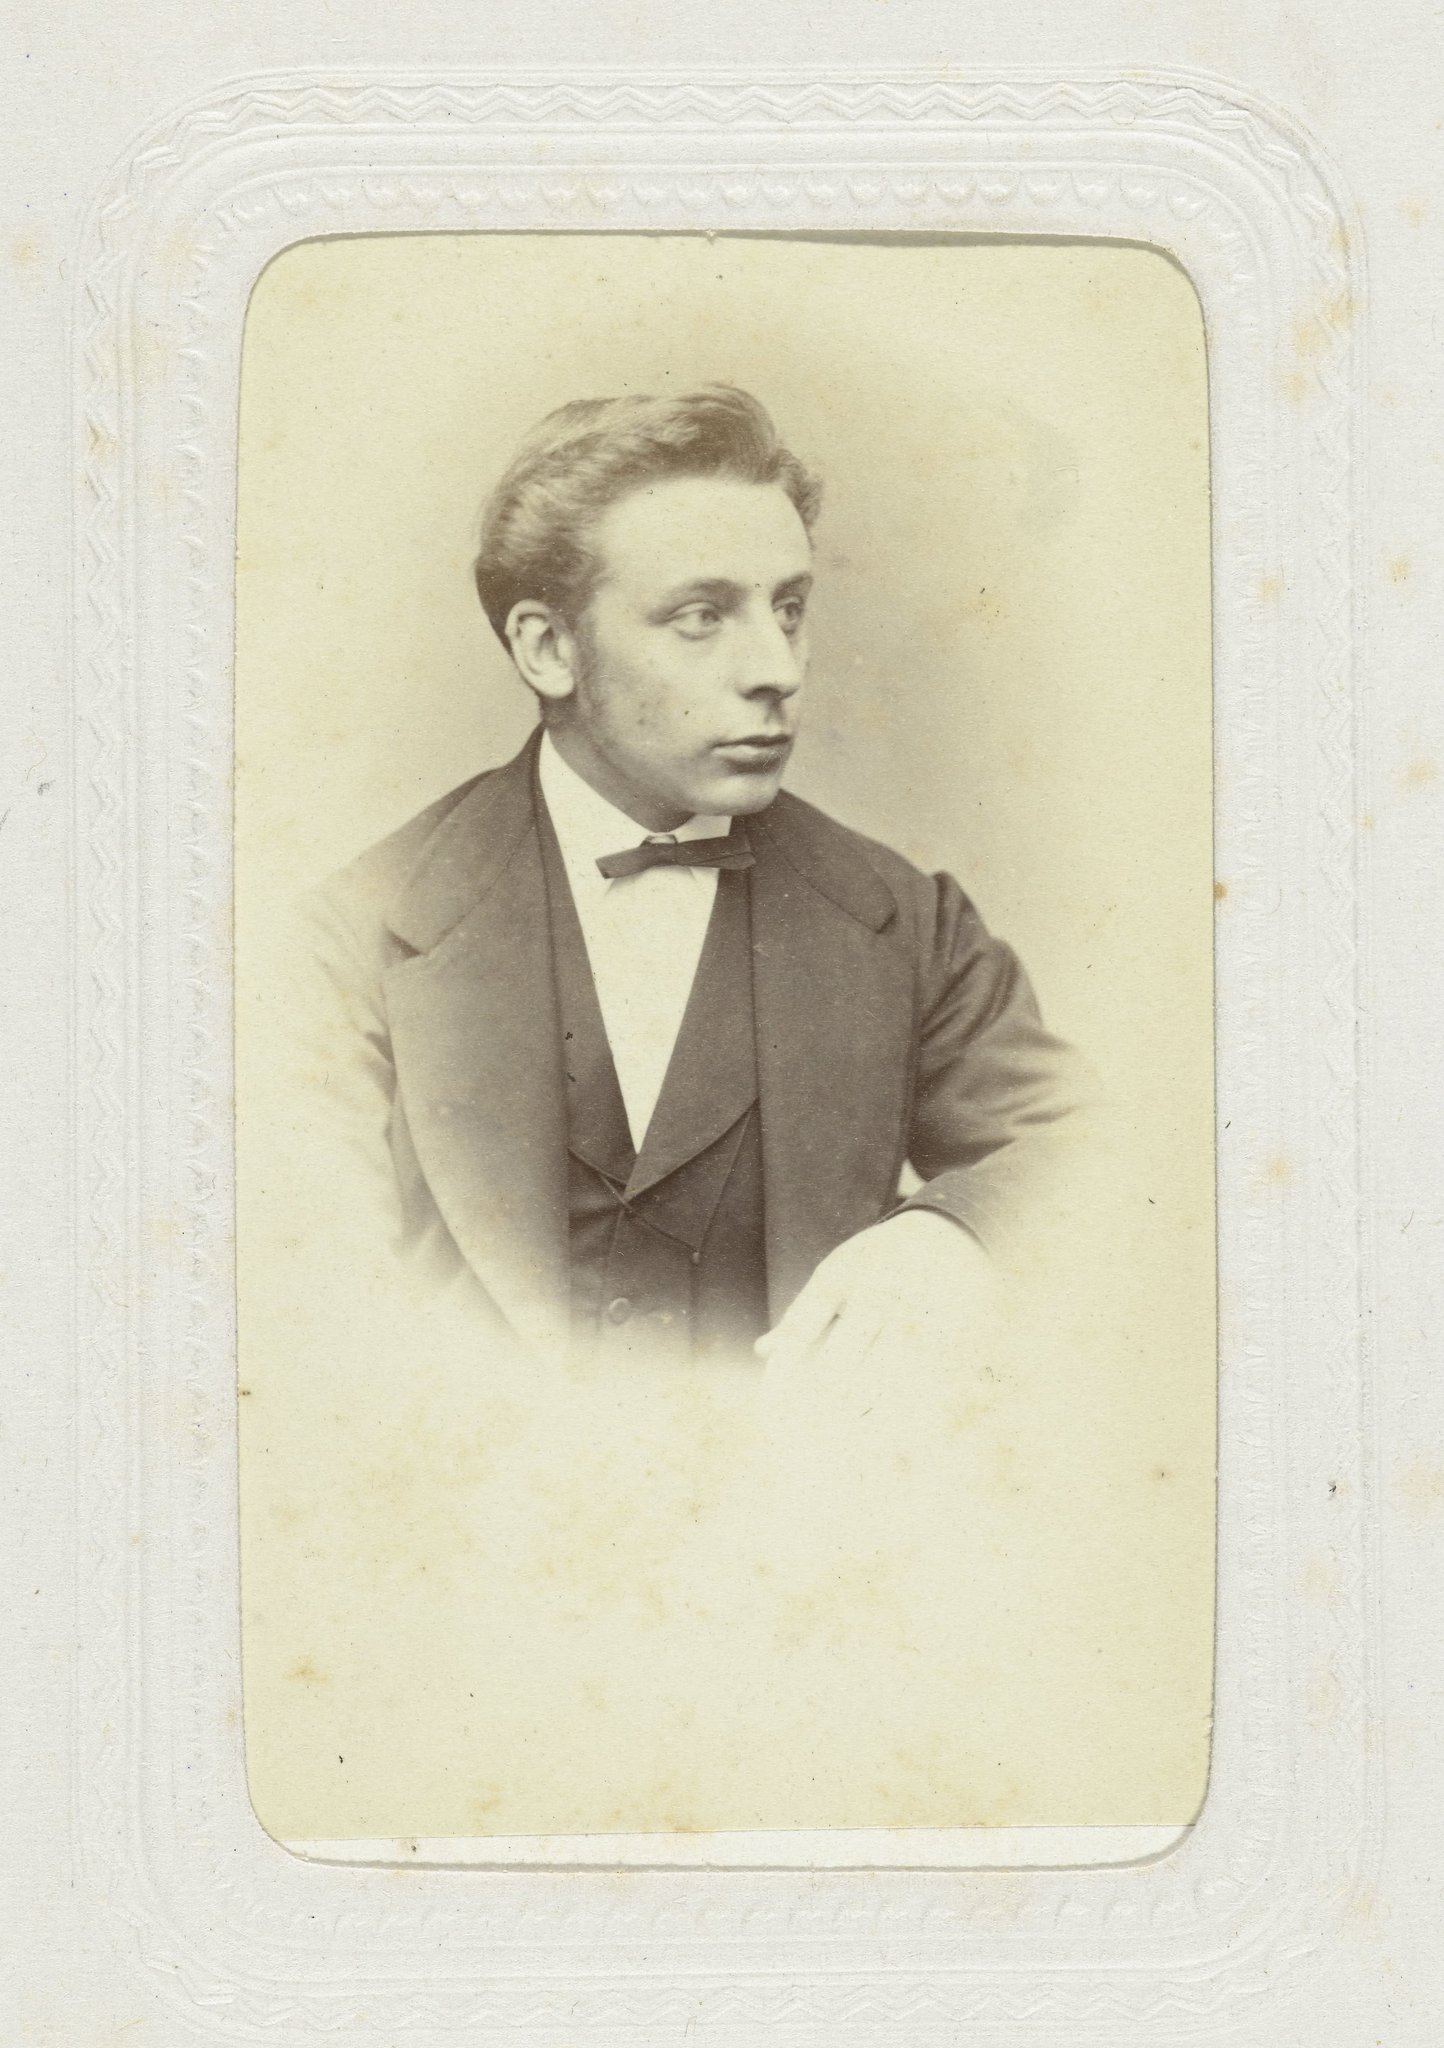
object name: carte de visite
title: Studioportret van een man in kostuum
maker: albert greiner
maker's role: fotograaf, fotostudio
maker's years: 1833-1890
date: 1863-1866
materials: cardboard, paper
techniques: albumen print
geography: amsterdam